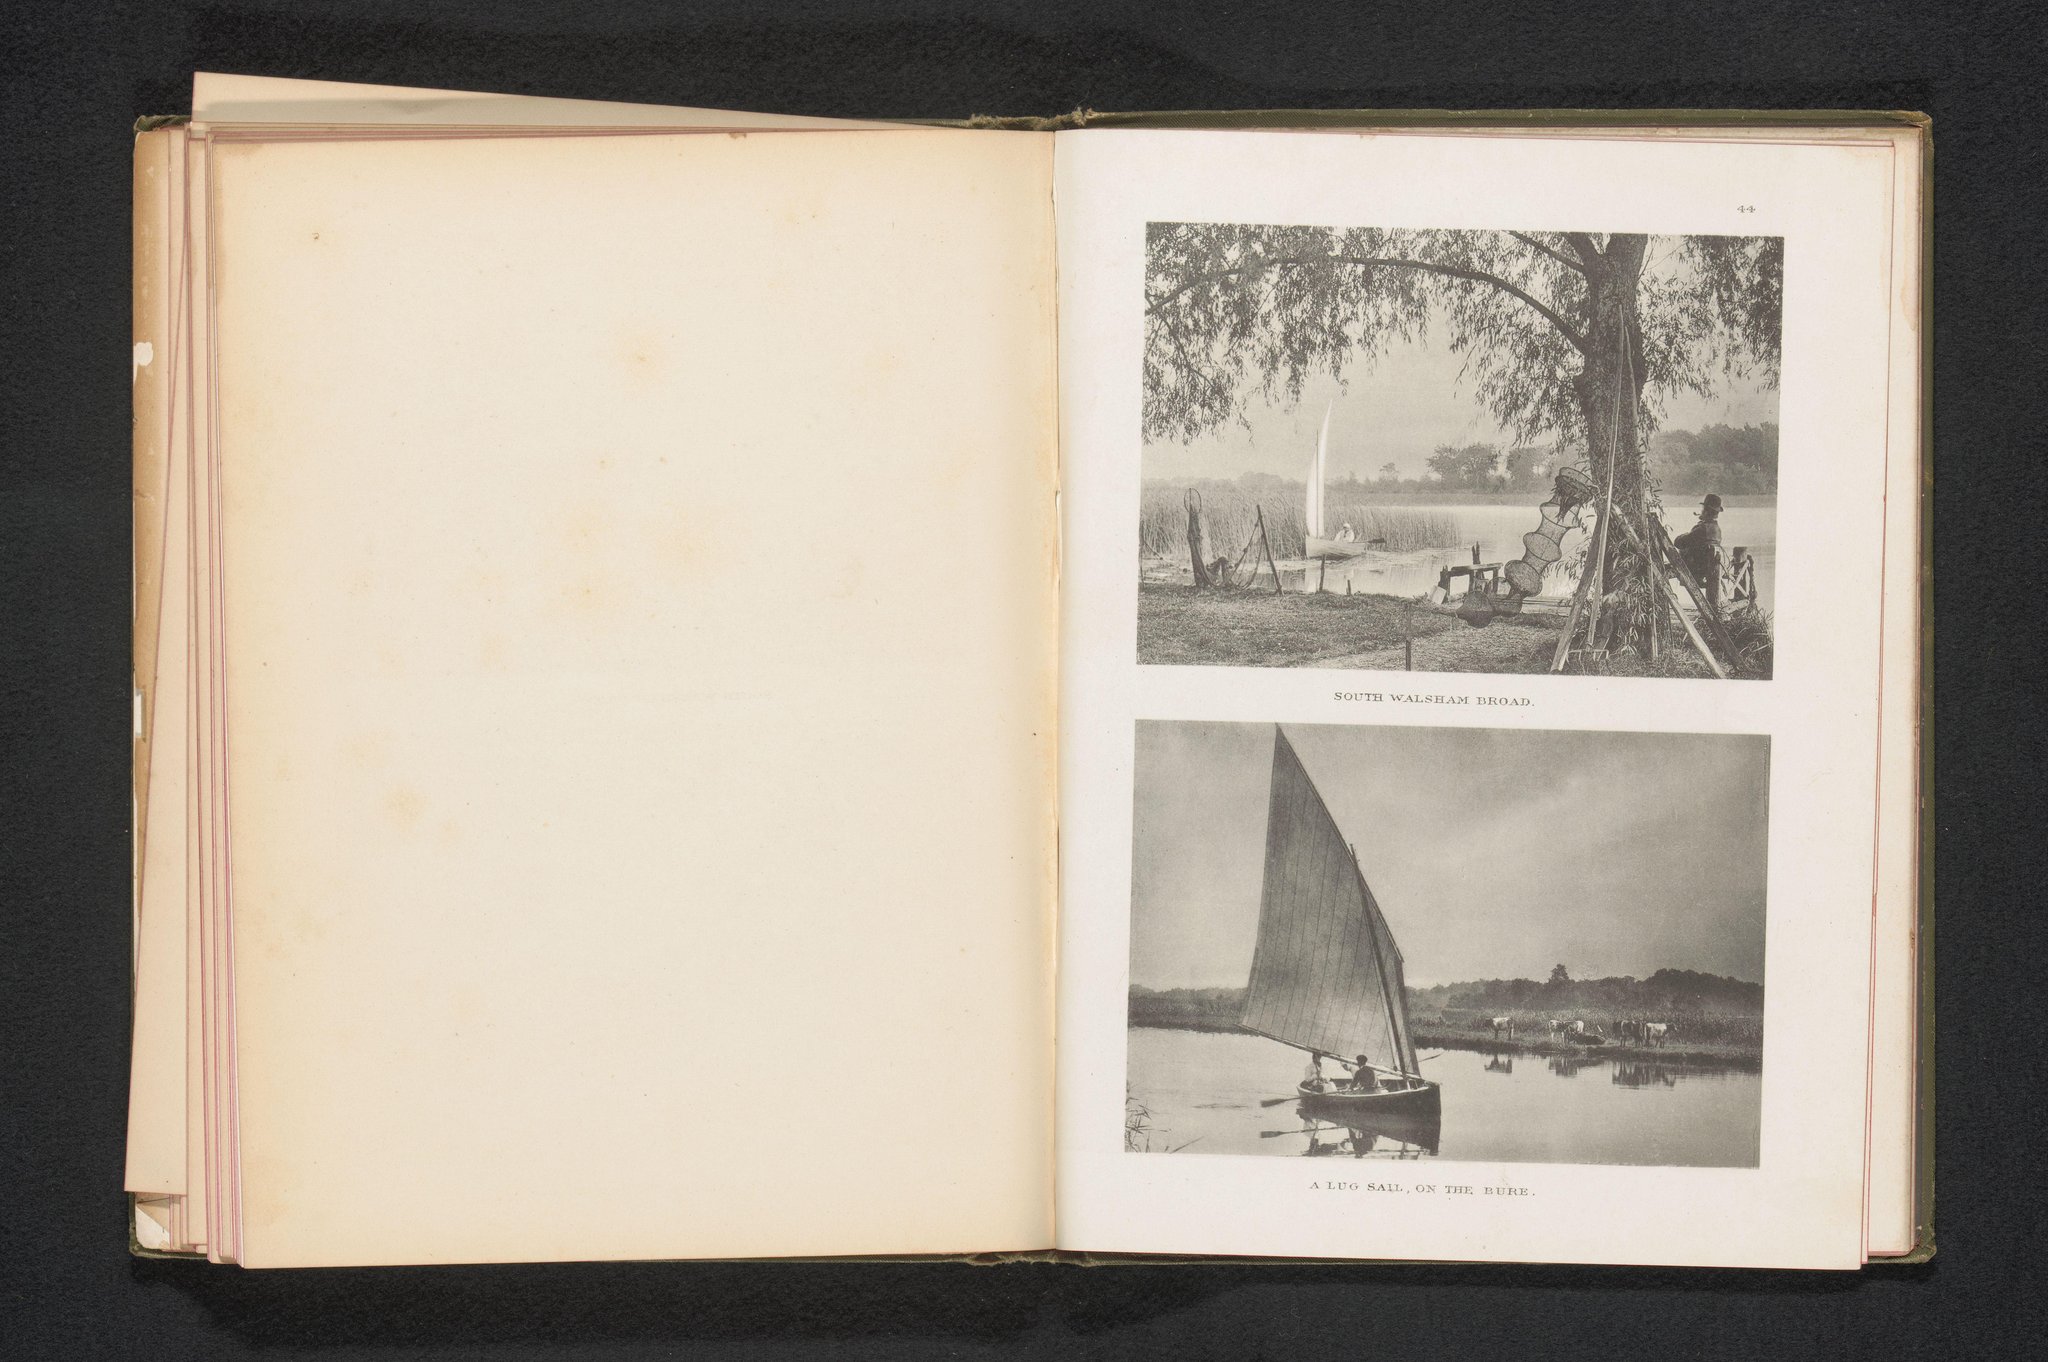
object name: photomechanical print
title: Gezicht op South Walsham Broad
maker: john payne jennings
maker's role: fotograaf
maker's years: 1843-1926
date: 1886-1891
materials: paper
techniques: photograph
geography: surrey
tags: landscapes with waters, waterscapes, seascapes (in the temperate zone), lake